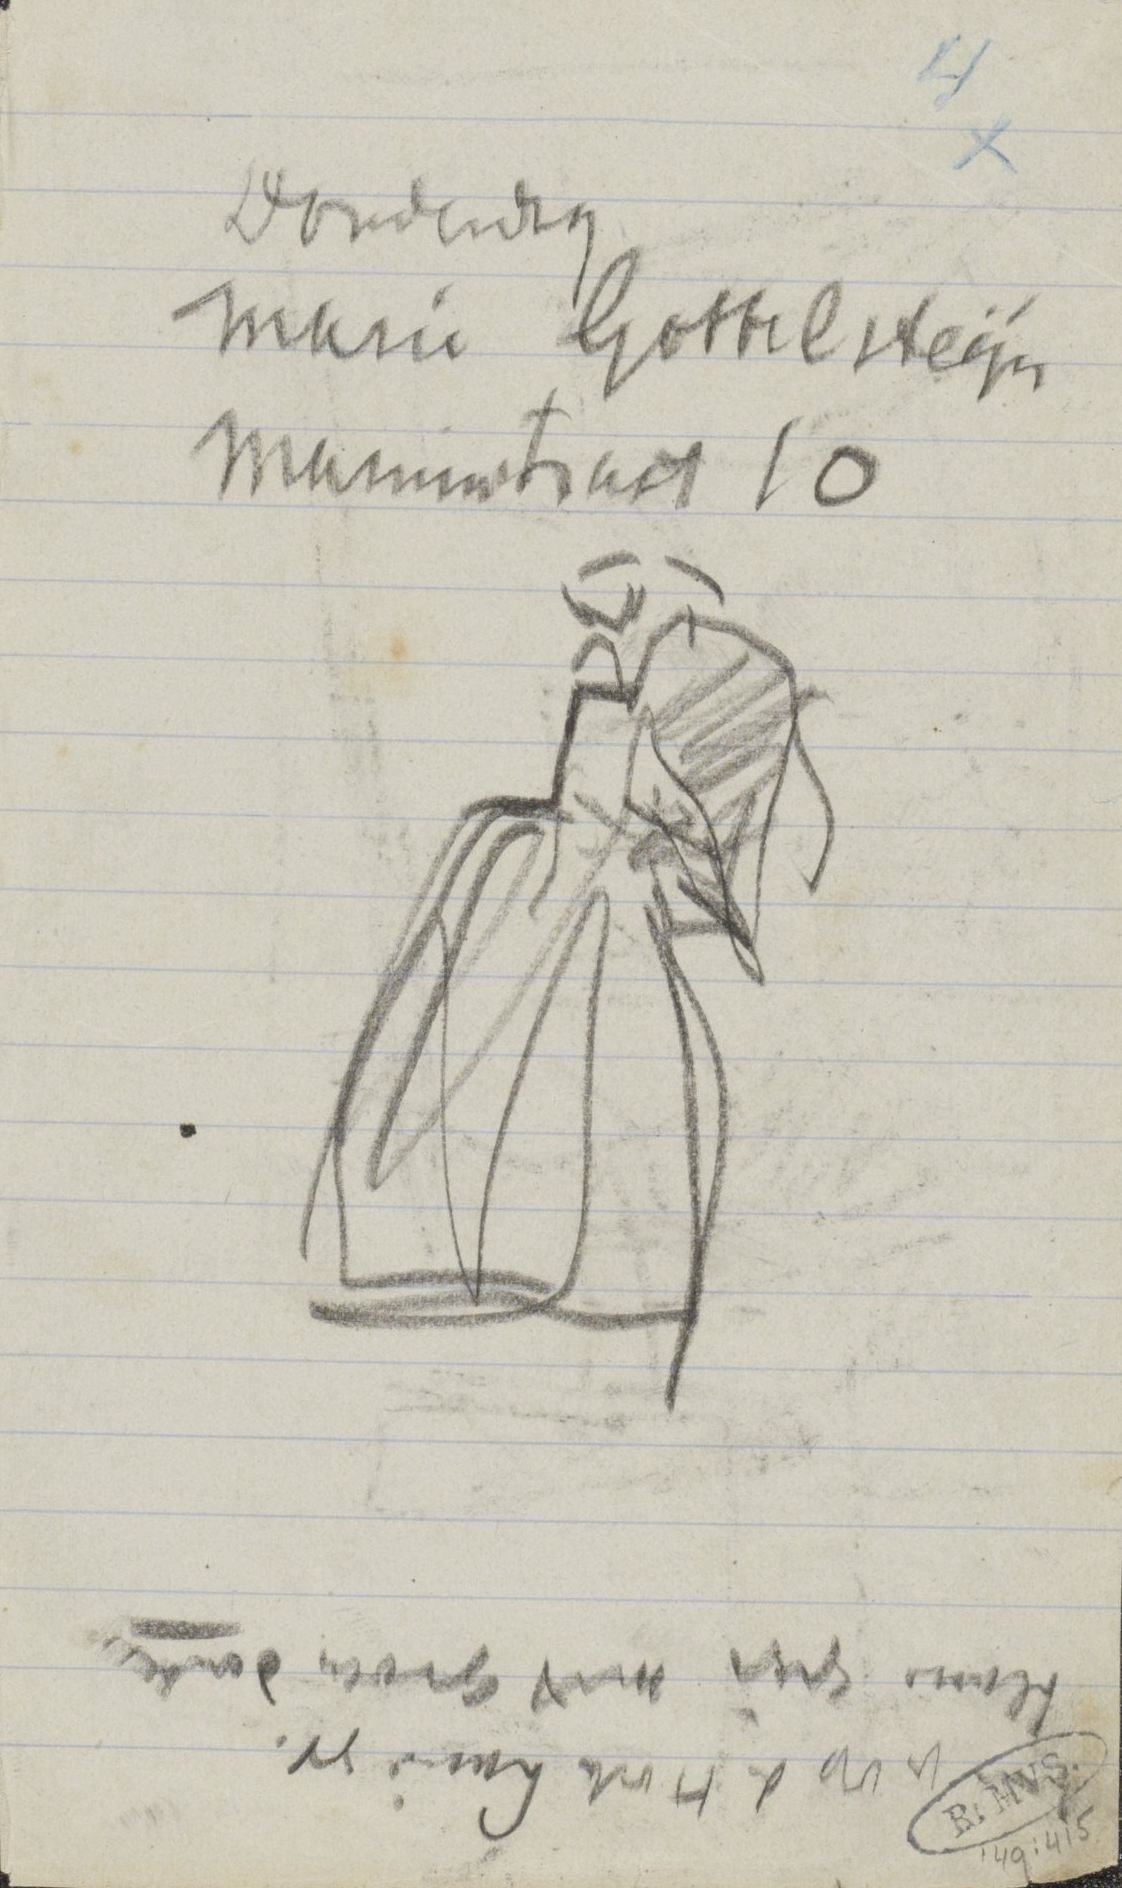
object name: drawing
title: Staande vrouw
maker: george hendrik breitner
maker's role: draughtsman, painter, print maker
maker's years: 1857-1923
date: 1897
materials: chalk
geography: amsterdam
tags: adult woman (+ standing)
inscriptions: annotation: ‘Donderdag/ Marie Gottilsteijn/ Marnixstraat 10/ is op de hoek Lauriergr.’, collector's mark: Lugt 2228